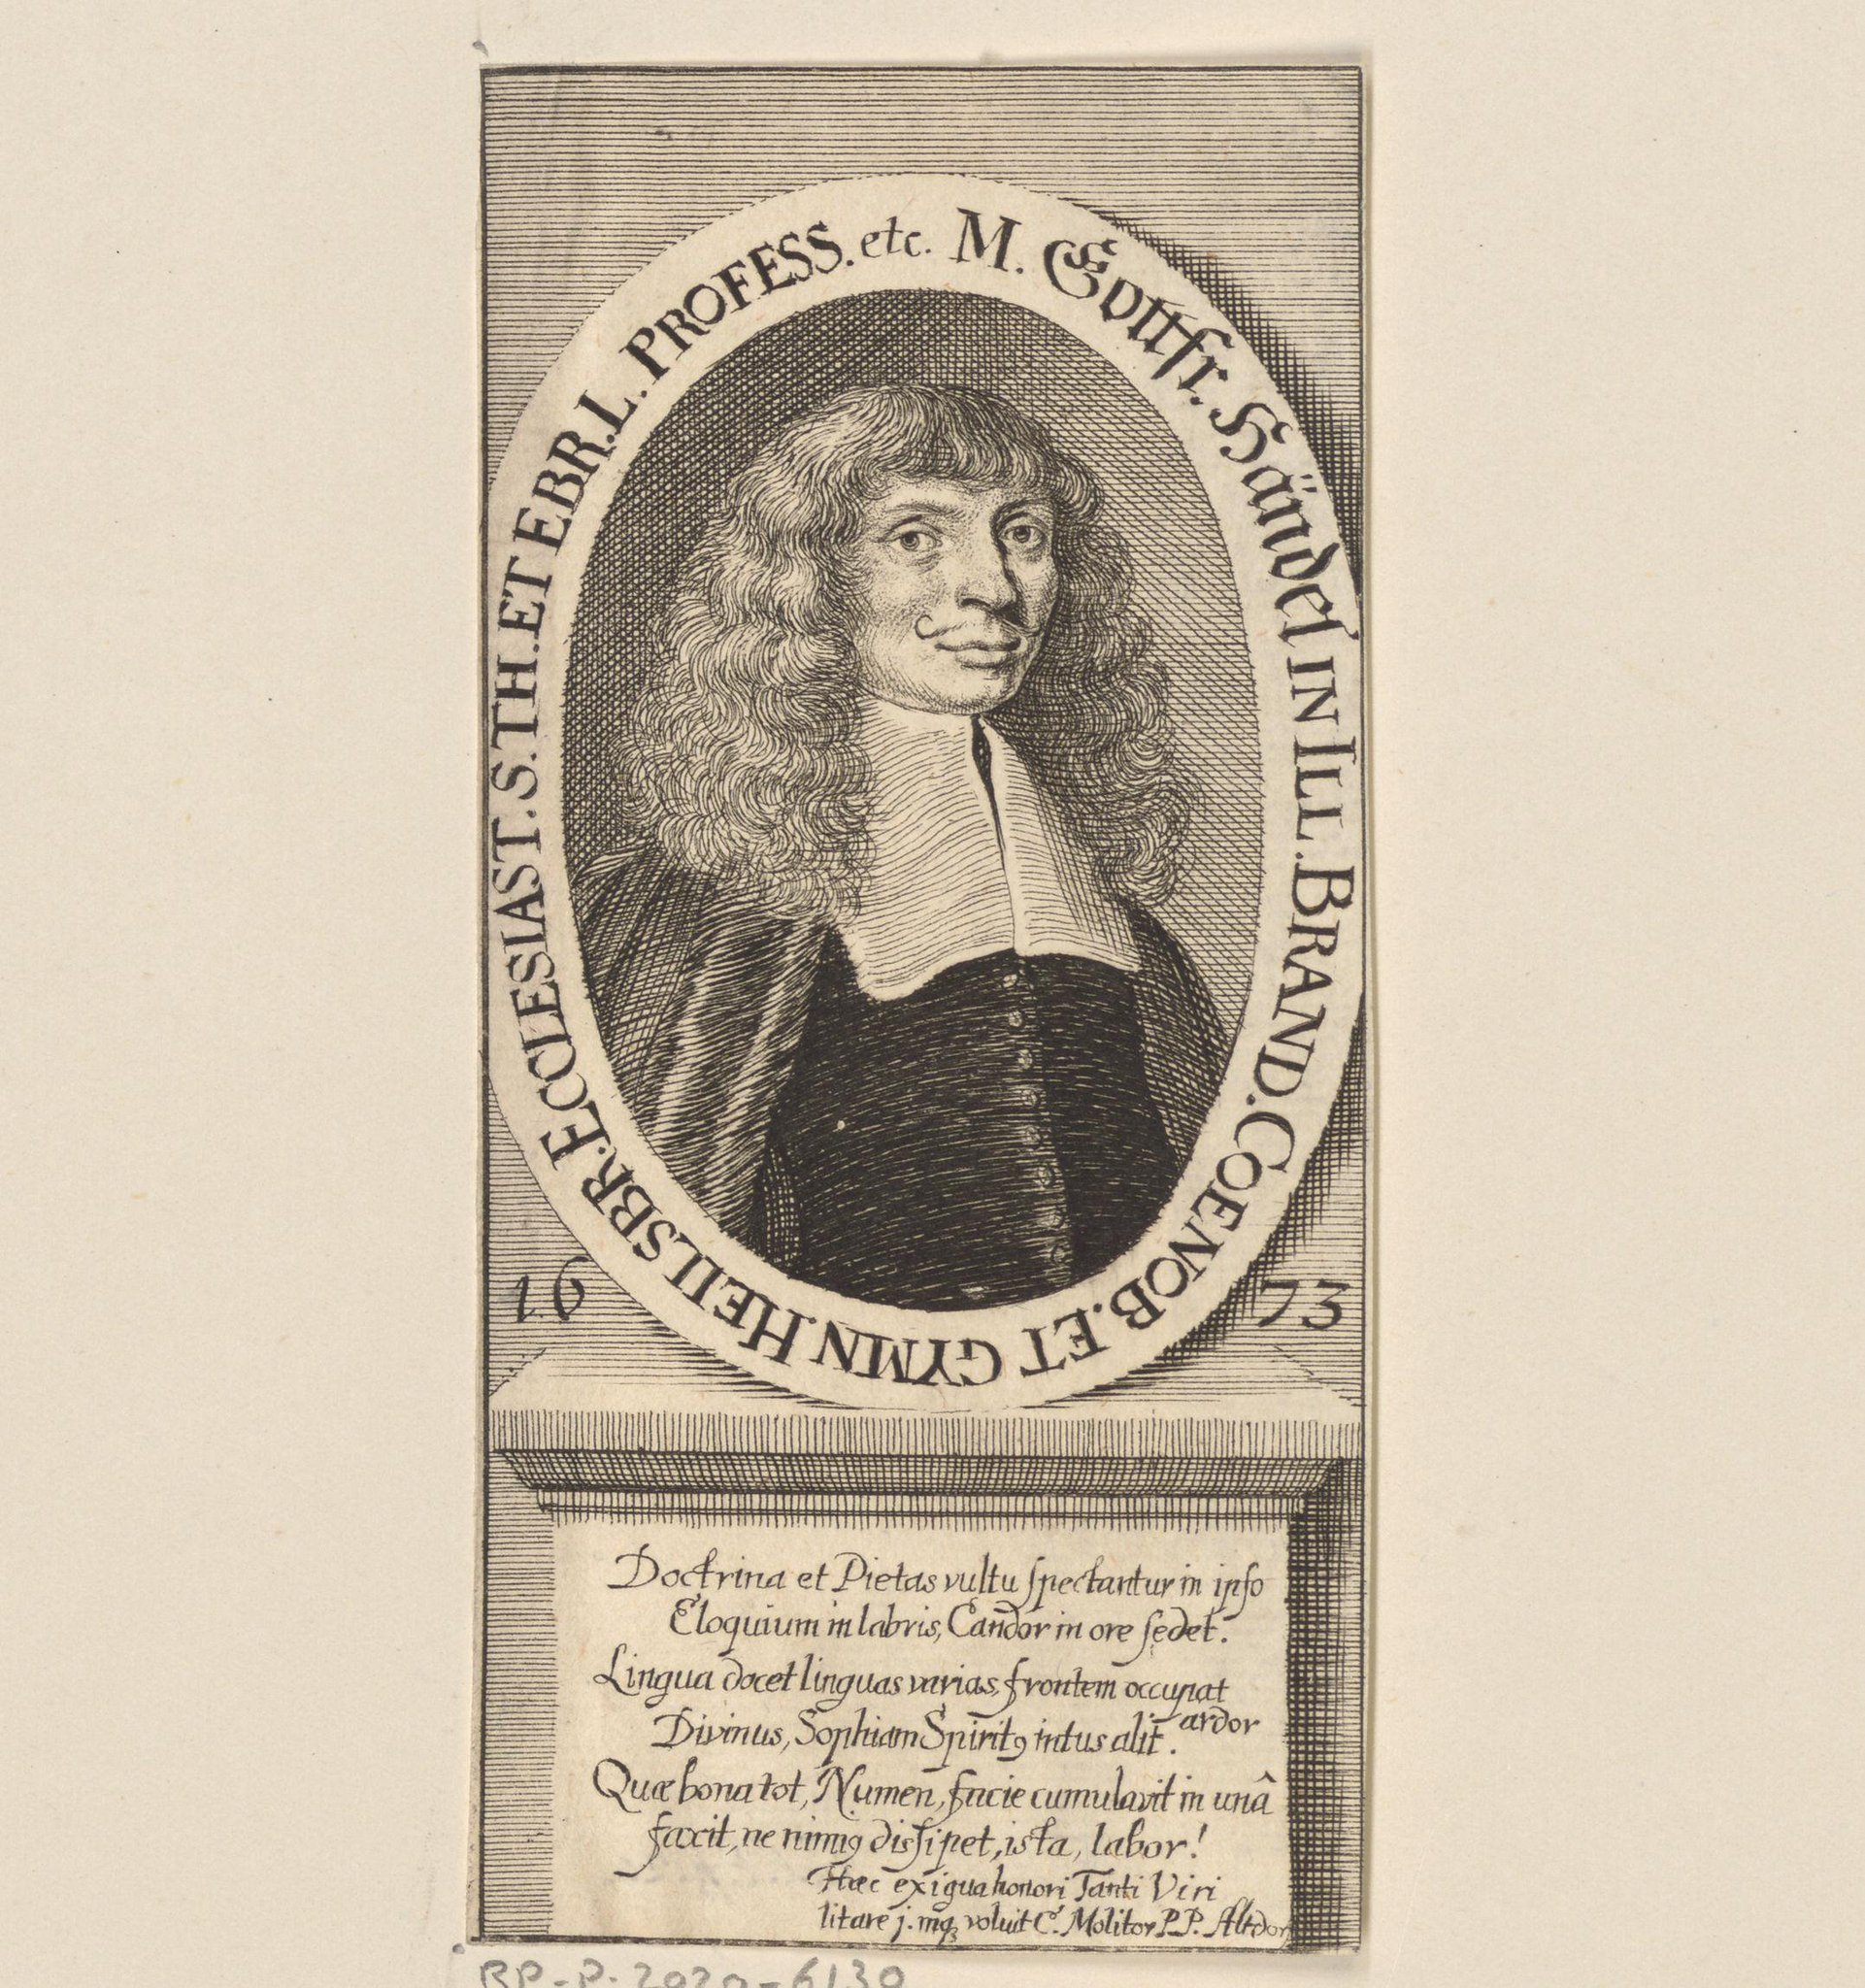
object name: print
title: Portret van Gottfried Händel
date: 1673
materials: paper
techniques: engraving, etching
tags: gottfried händel, theologian, historical persons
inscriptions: inscription: ‘Th.C.E.p.20.(?)’